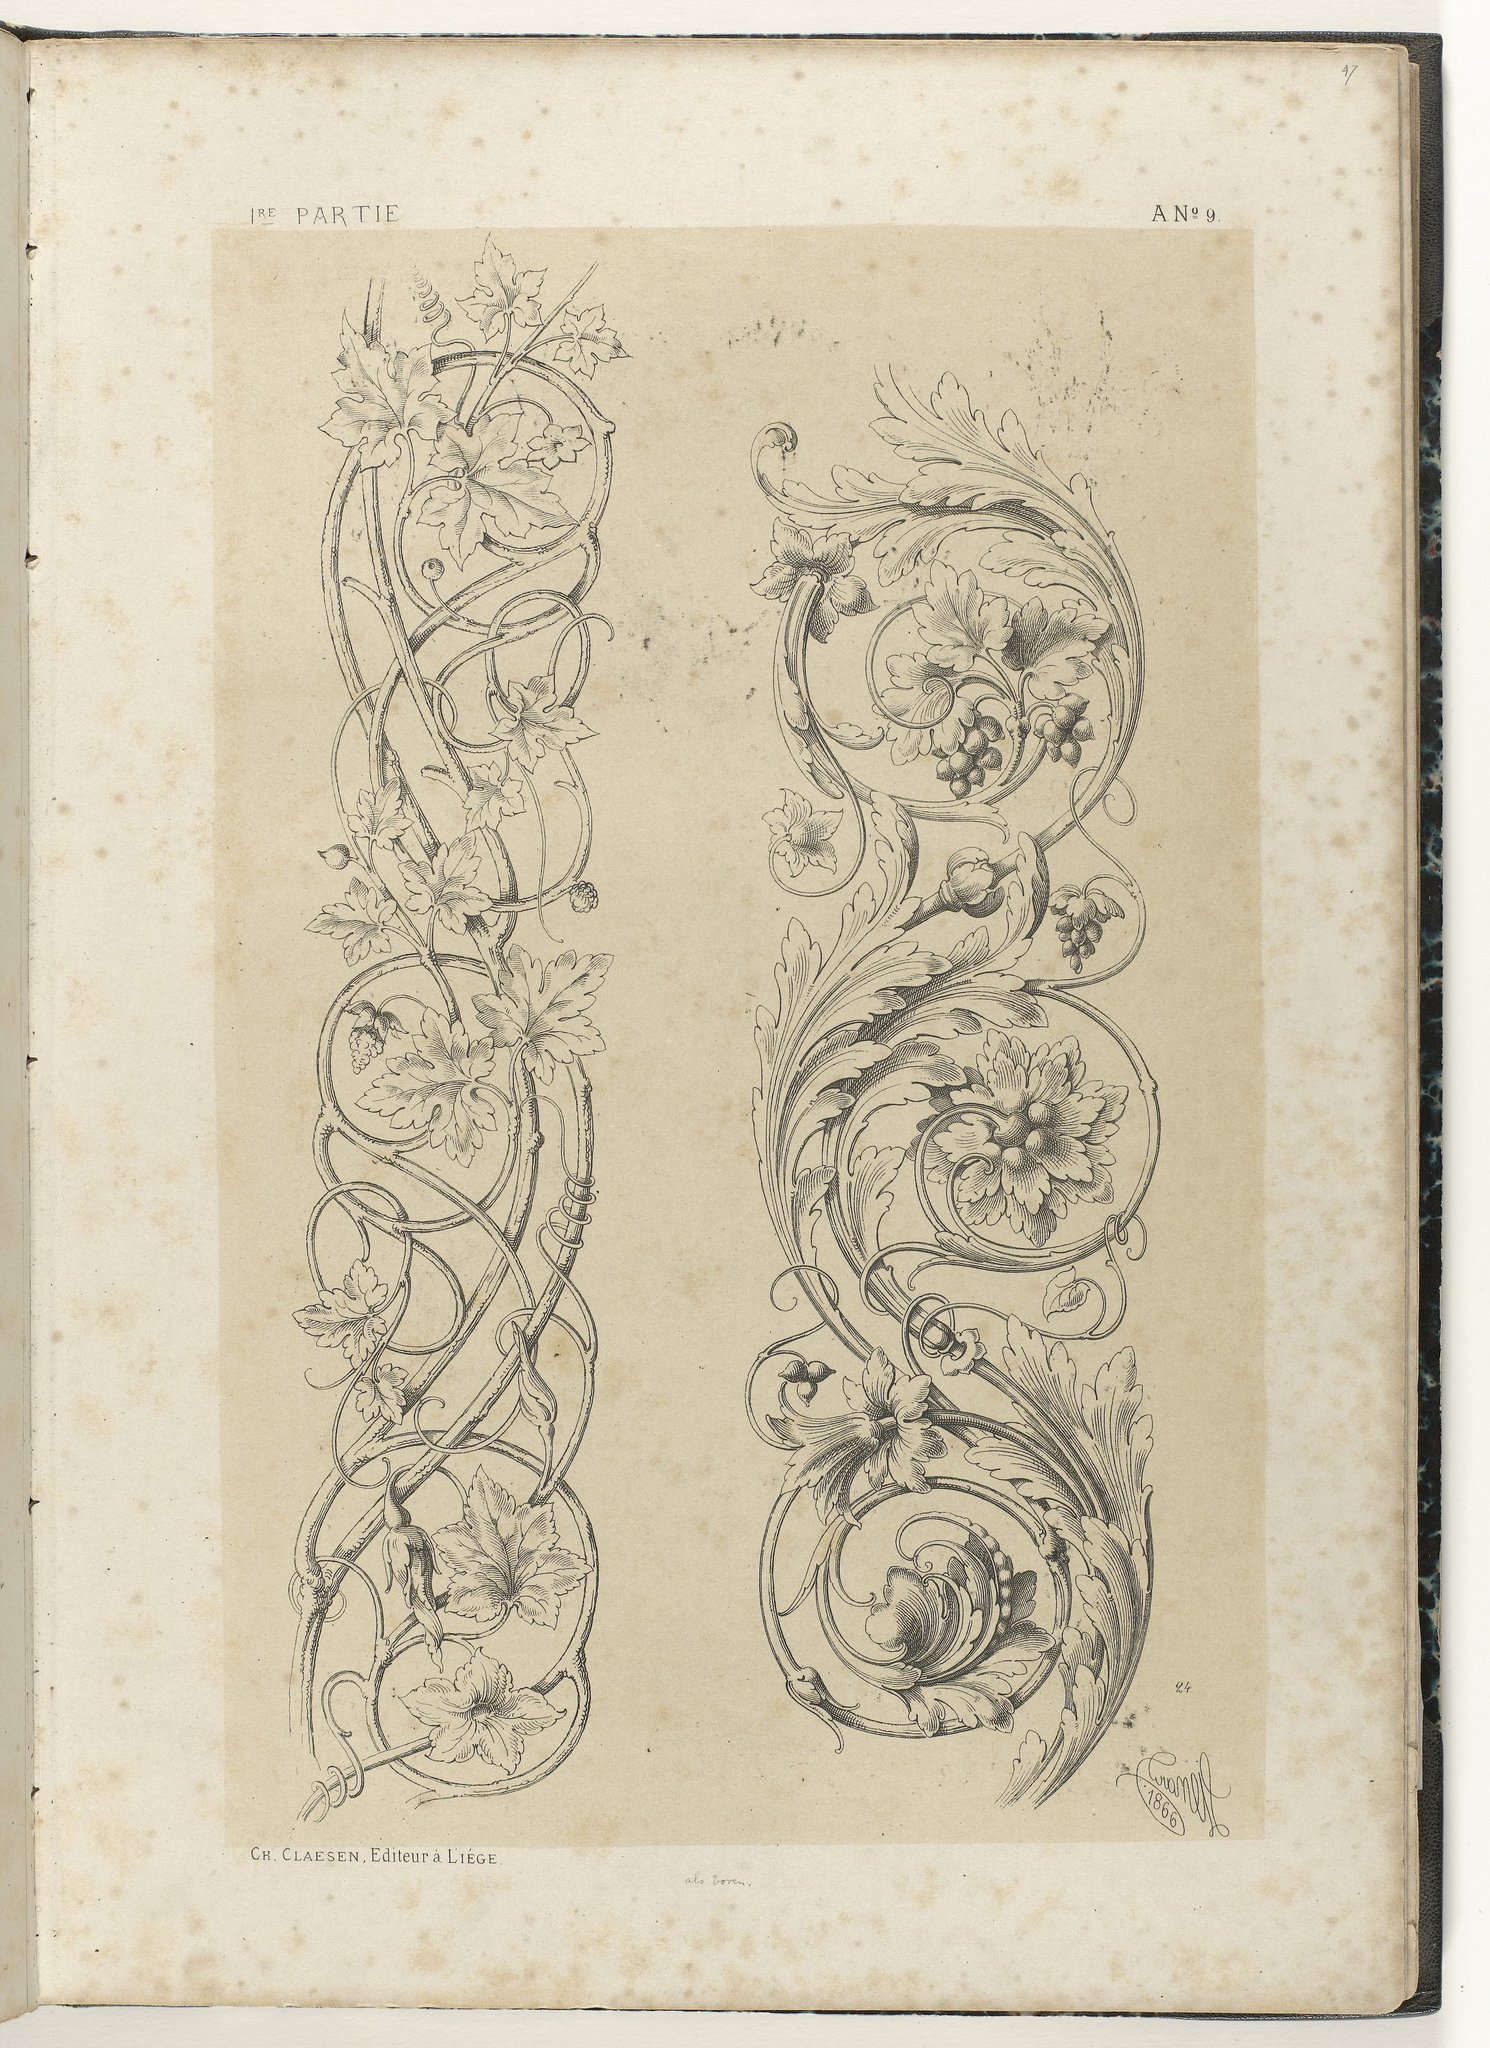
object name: print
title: Twee motieven van bladranken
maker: michel liénard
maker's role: print maker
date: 1866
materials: paper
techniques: tone lithography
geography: liège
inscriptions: annotation: ‘als voren.’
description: Linksboven staat gedrukt: 1re partie, rechtsboven: A N° 9., rechtsonder: 24.